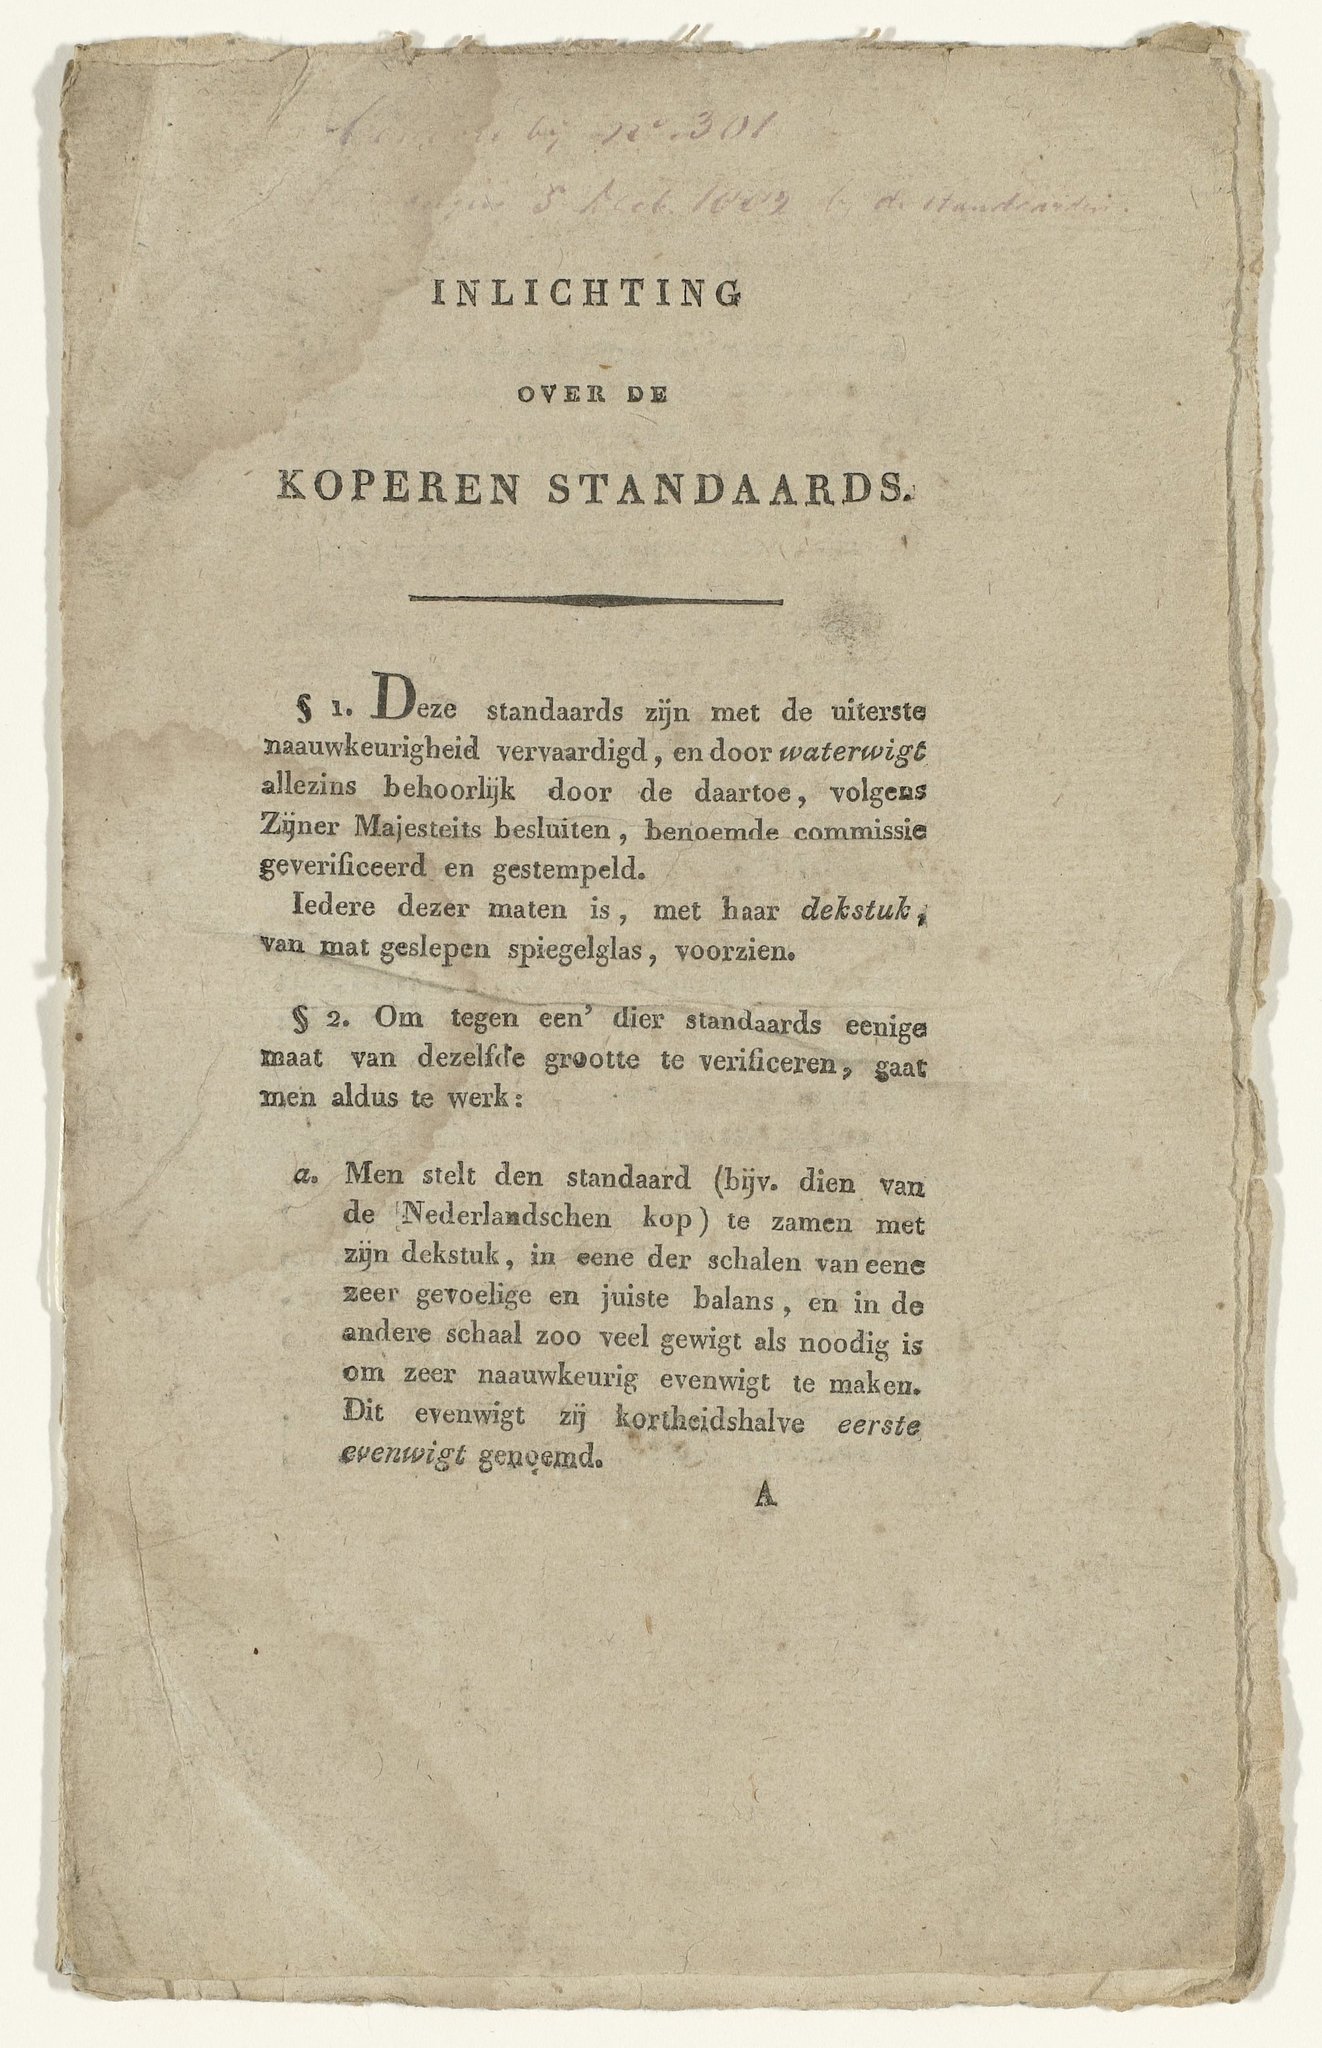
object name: document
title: Inlichting over de koperen standaards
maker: Anonymous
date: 1820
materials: paper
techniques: printing, writing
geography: amsterdam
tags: netherlands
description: Een gedrukte 'gebruiksaanwijzing', getiteld: 'Inlichting over de koperen standaards'. Met rode inkt is hierop geschreven: 'behoort bij no. 301 ontvangen 5 deeb. 1882 bij de standaarden'. Behoord samen met acht inhoudsmaten voor natte waren in grijs geschilderde kist.